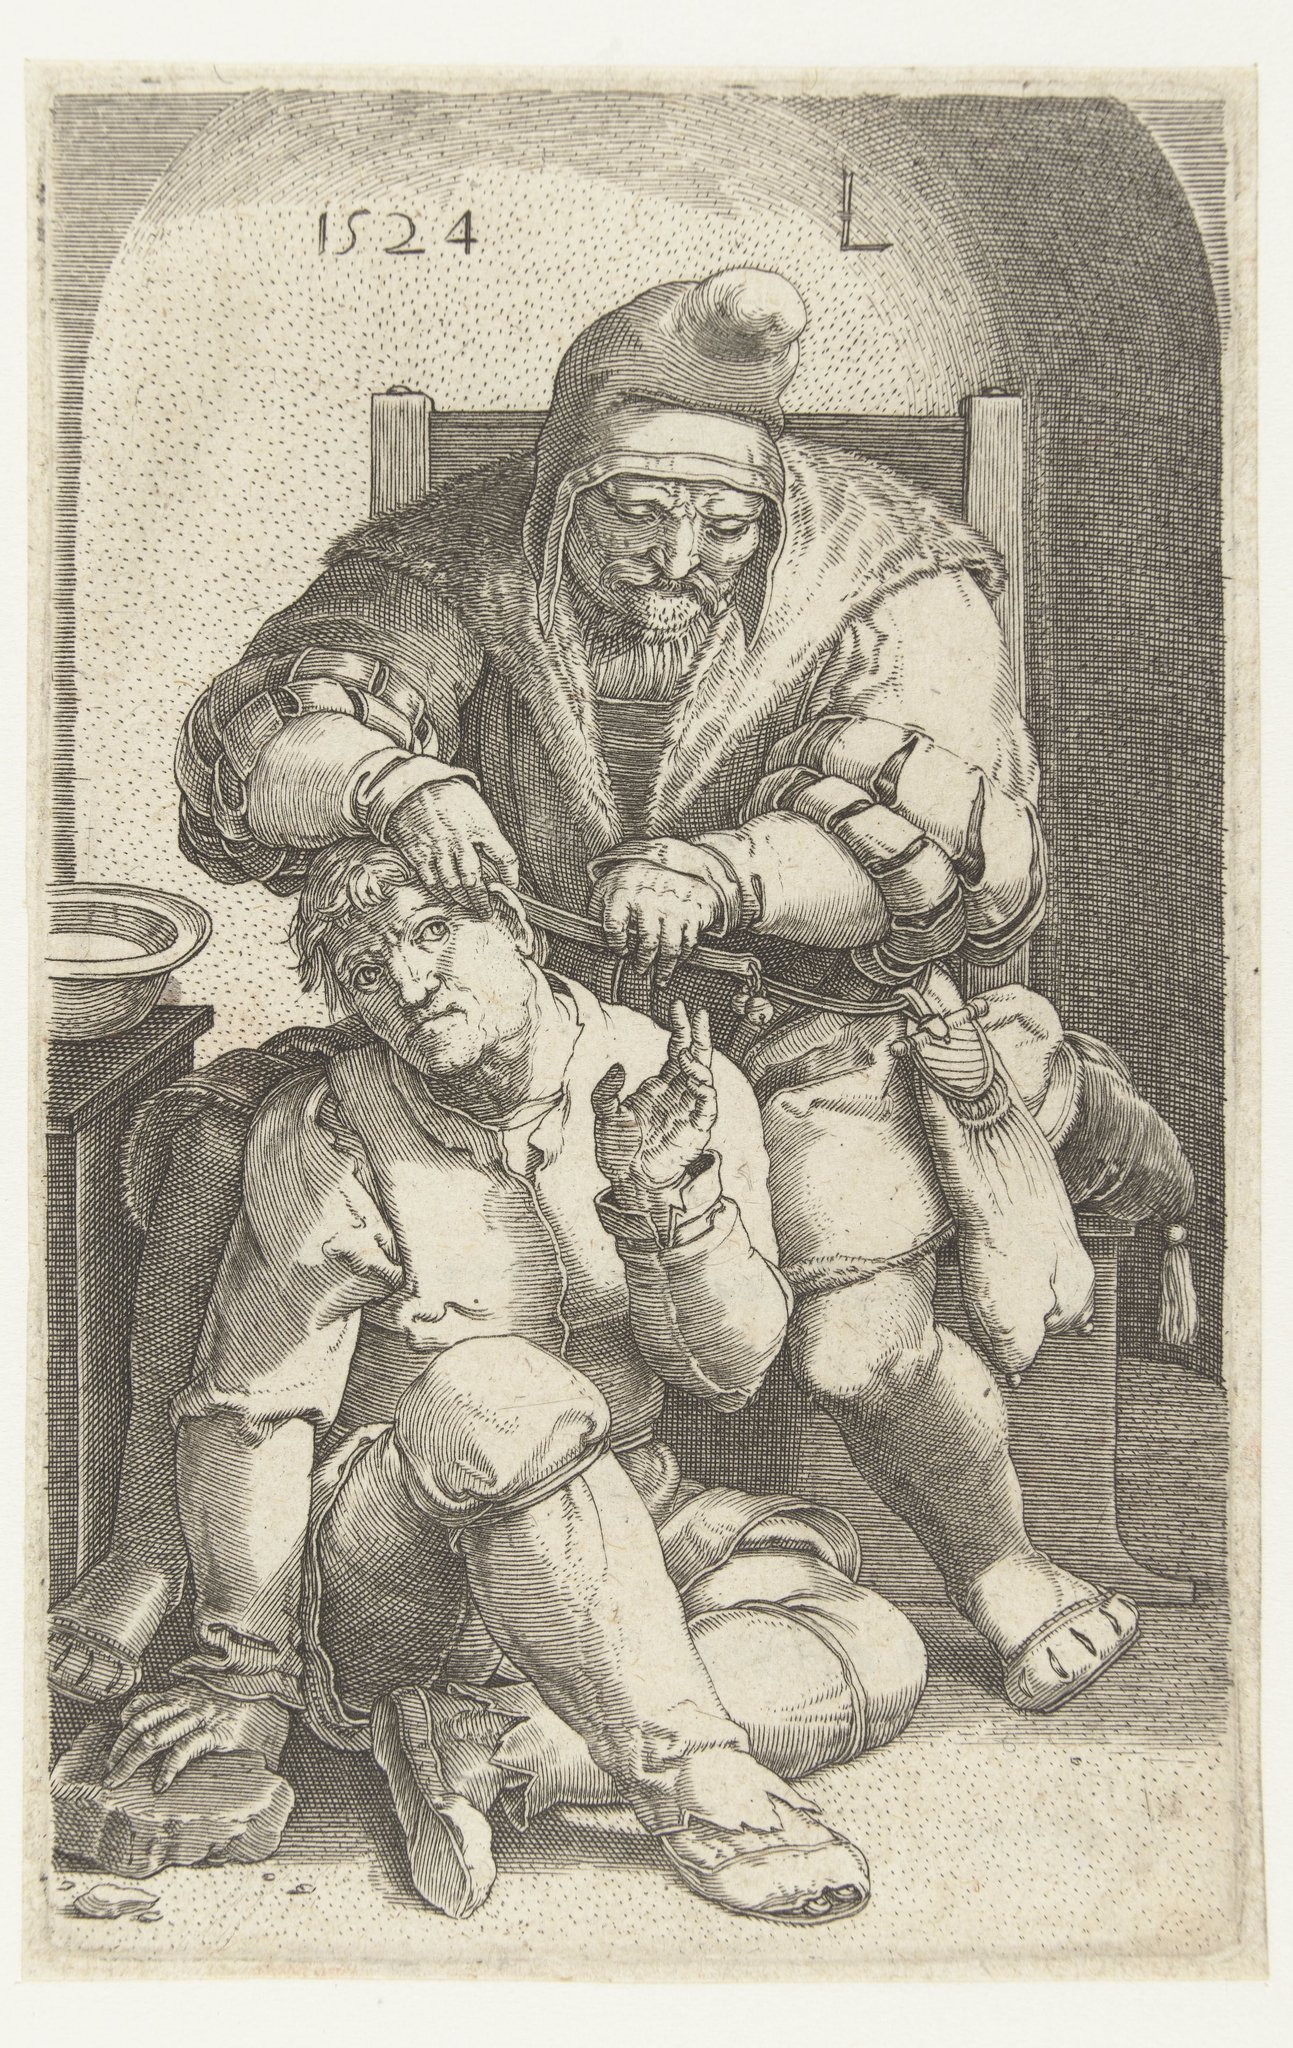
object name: print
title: De chirurgijn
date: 1581-1628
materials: paper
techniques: engraving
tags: barber; surgeon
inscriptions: collector's mark: Lugt 2228a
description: Kopie in spiegelbeeld. Een chirurgijn maakt een insnijding achter het oor van een voor hem op de grond zittende man.